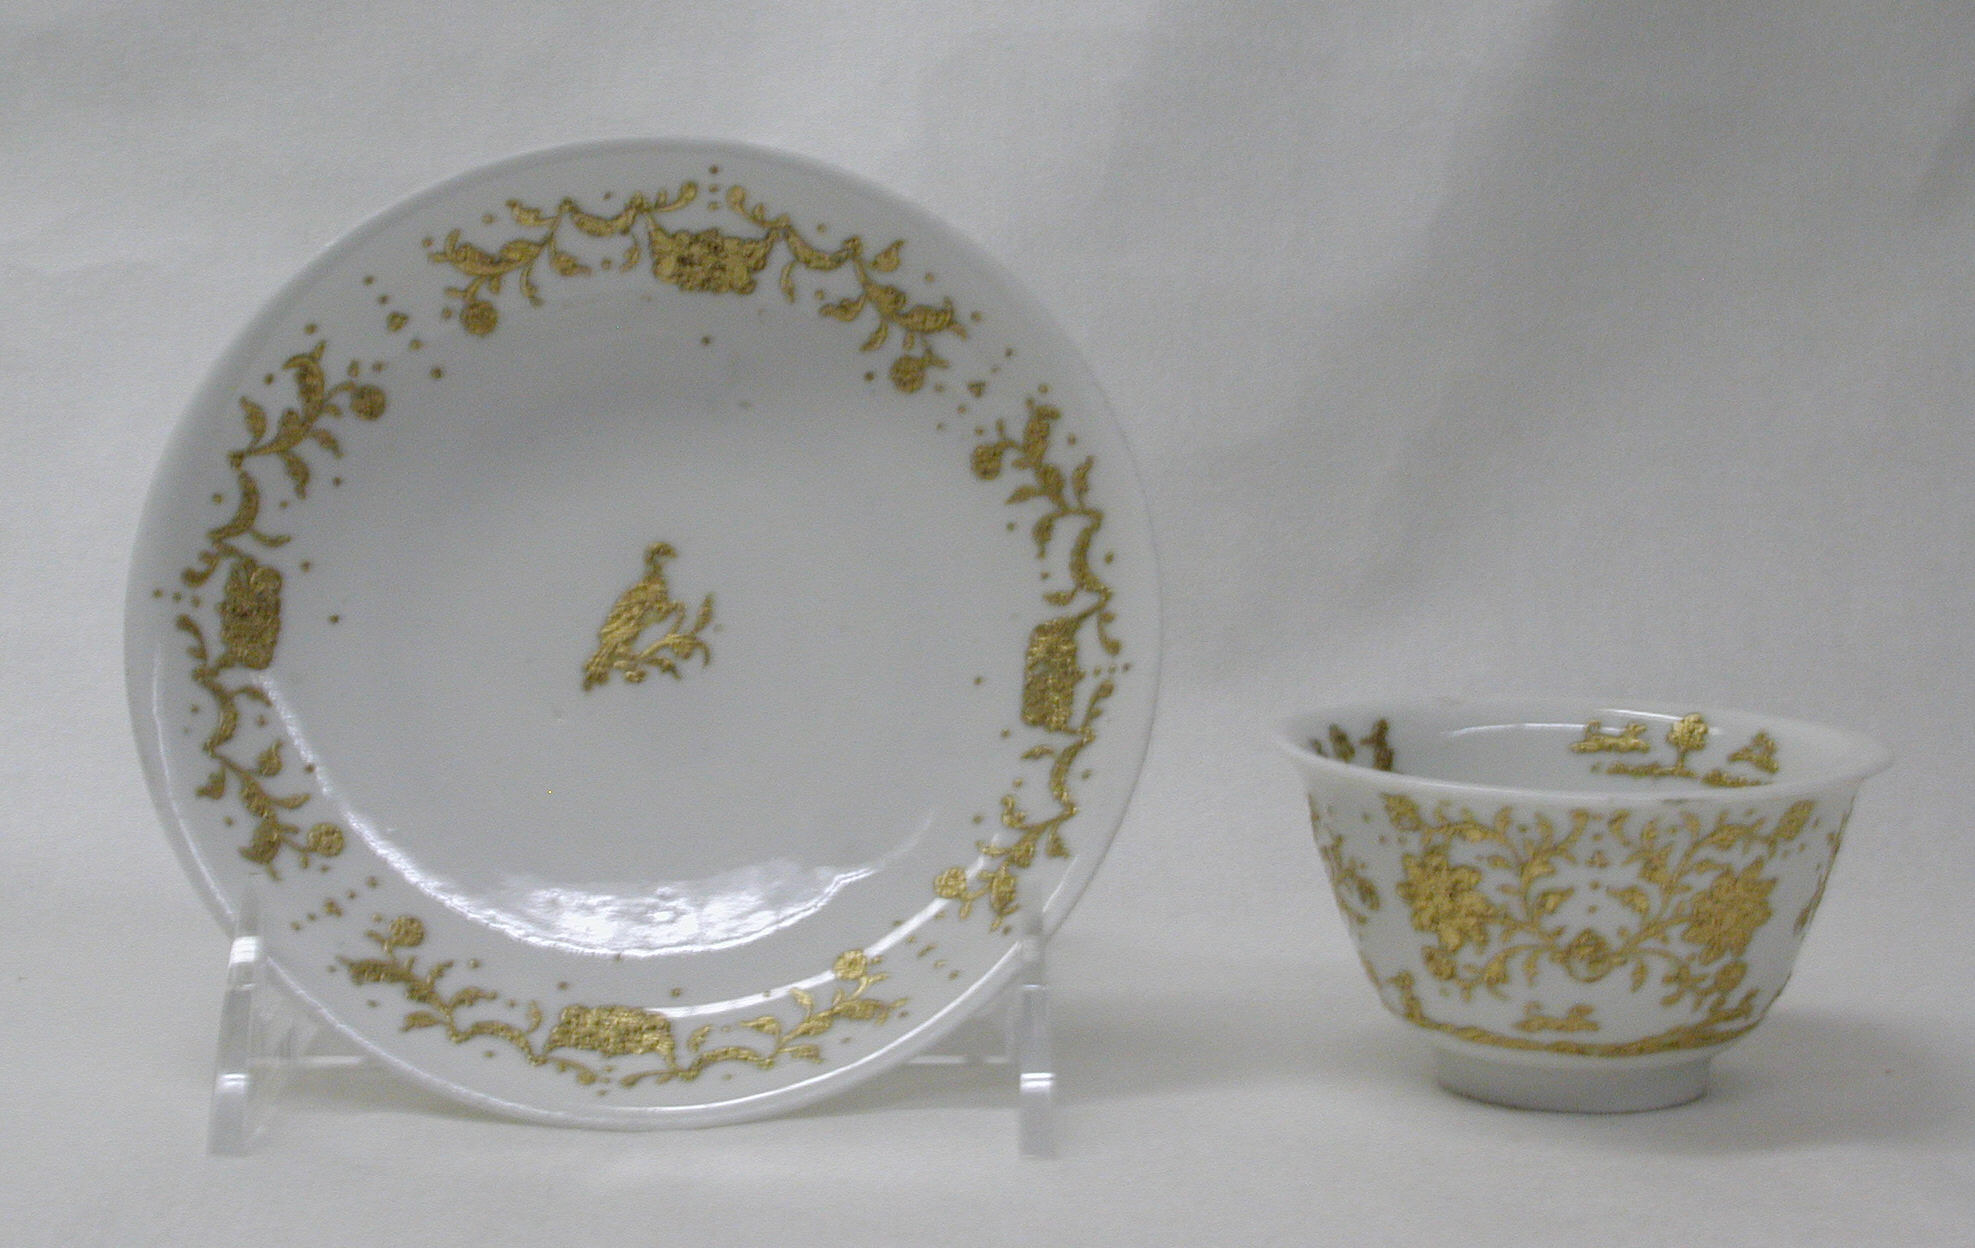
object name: saucer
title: Saucer (1 of 6) (part of a service)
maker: meissen manufactory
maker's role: manufactory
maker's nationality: german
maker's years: 1710-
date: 1720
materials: hard paste porcelain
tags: birds,flowers